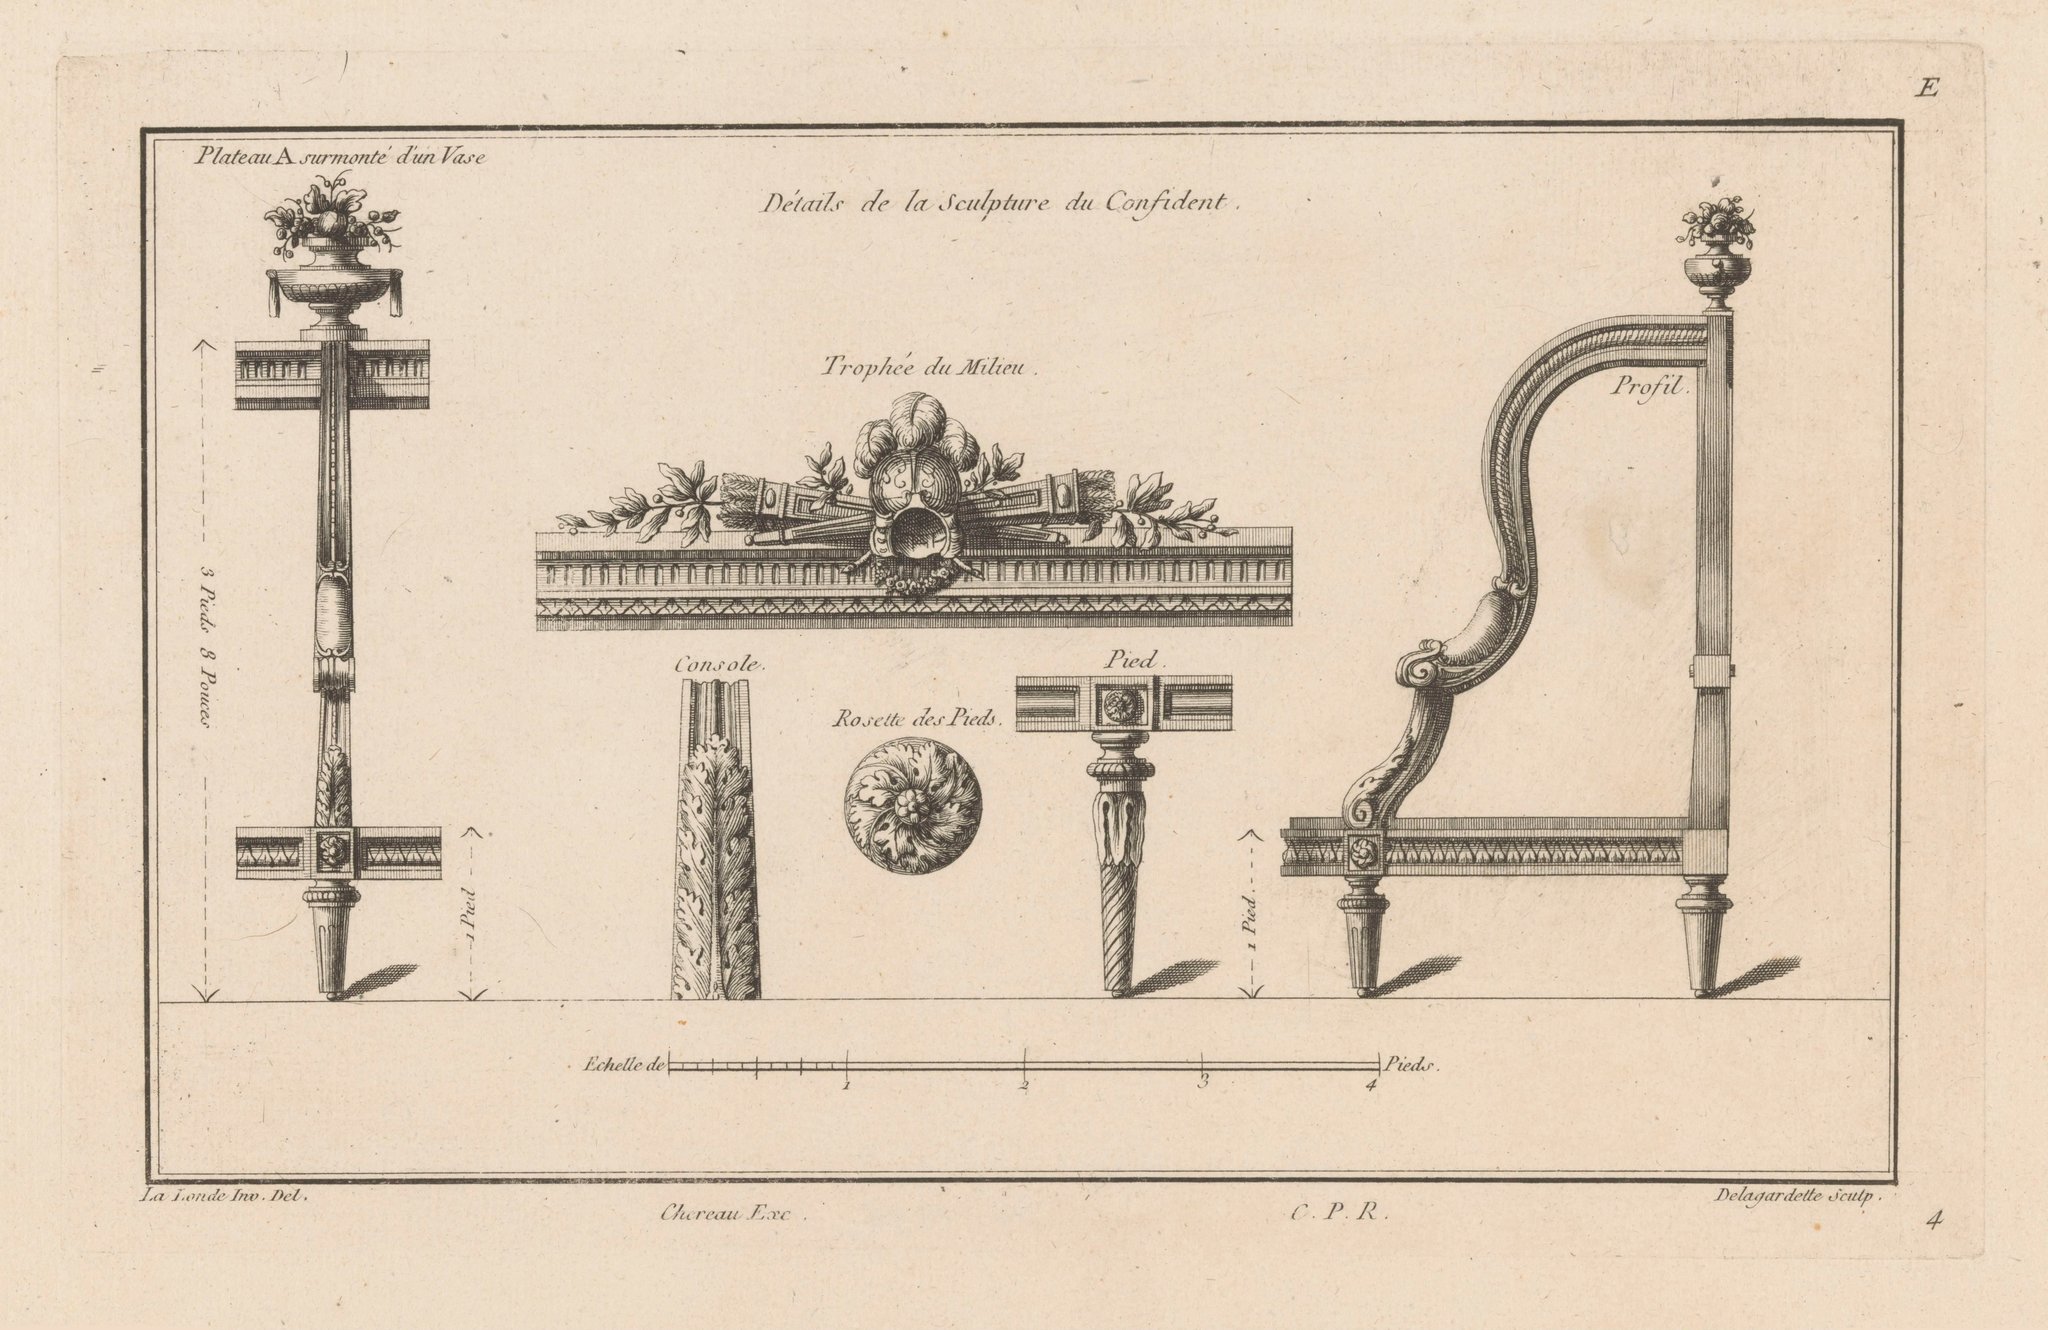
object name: print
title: E Veme Cahier d'Ameublemens Dessinés par La Londe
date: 1784-1785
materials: paper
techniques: etching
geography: paris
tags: bench, ornaments ~ art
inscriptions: collector's mark: Lugt 2760, collector's mark: Lugt 2228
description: Details van ornamenten van een bank zoals een vaas, een trofee, een console, een rozet en de poten. Rechts een profiel van de bank.